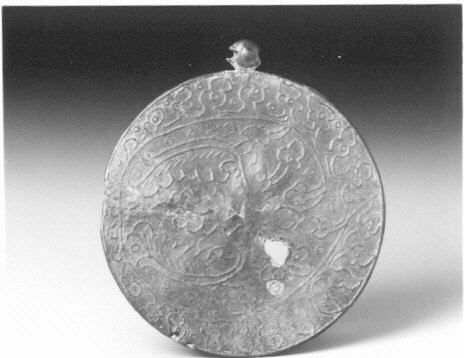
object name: pendant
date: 801-900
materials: tin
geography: egypt